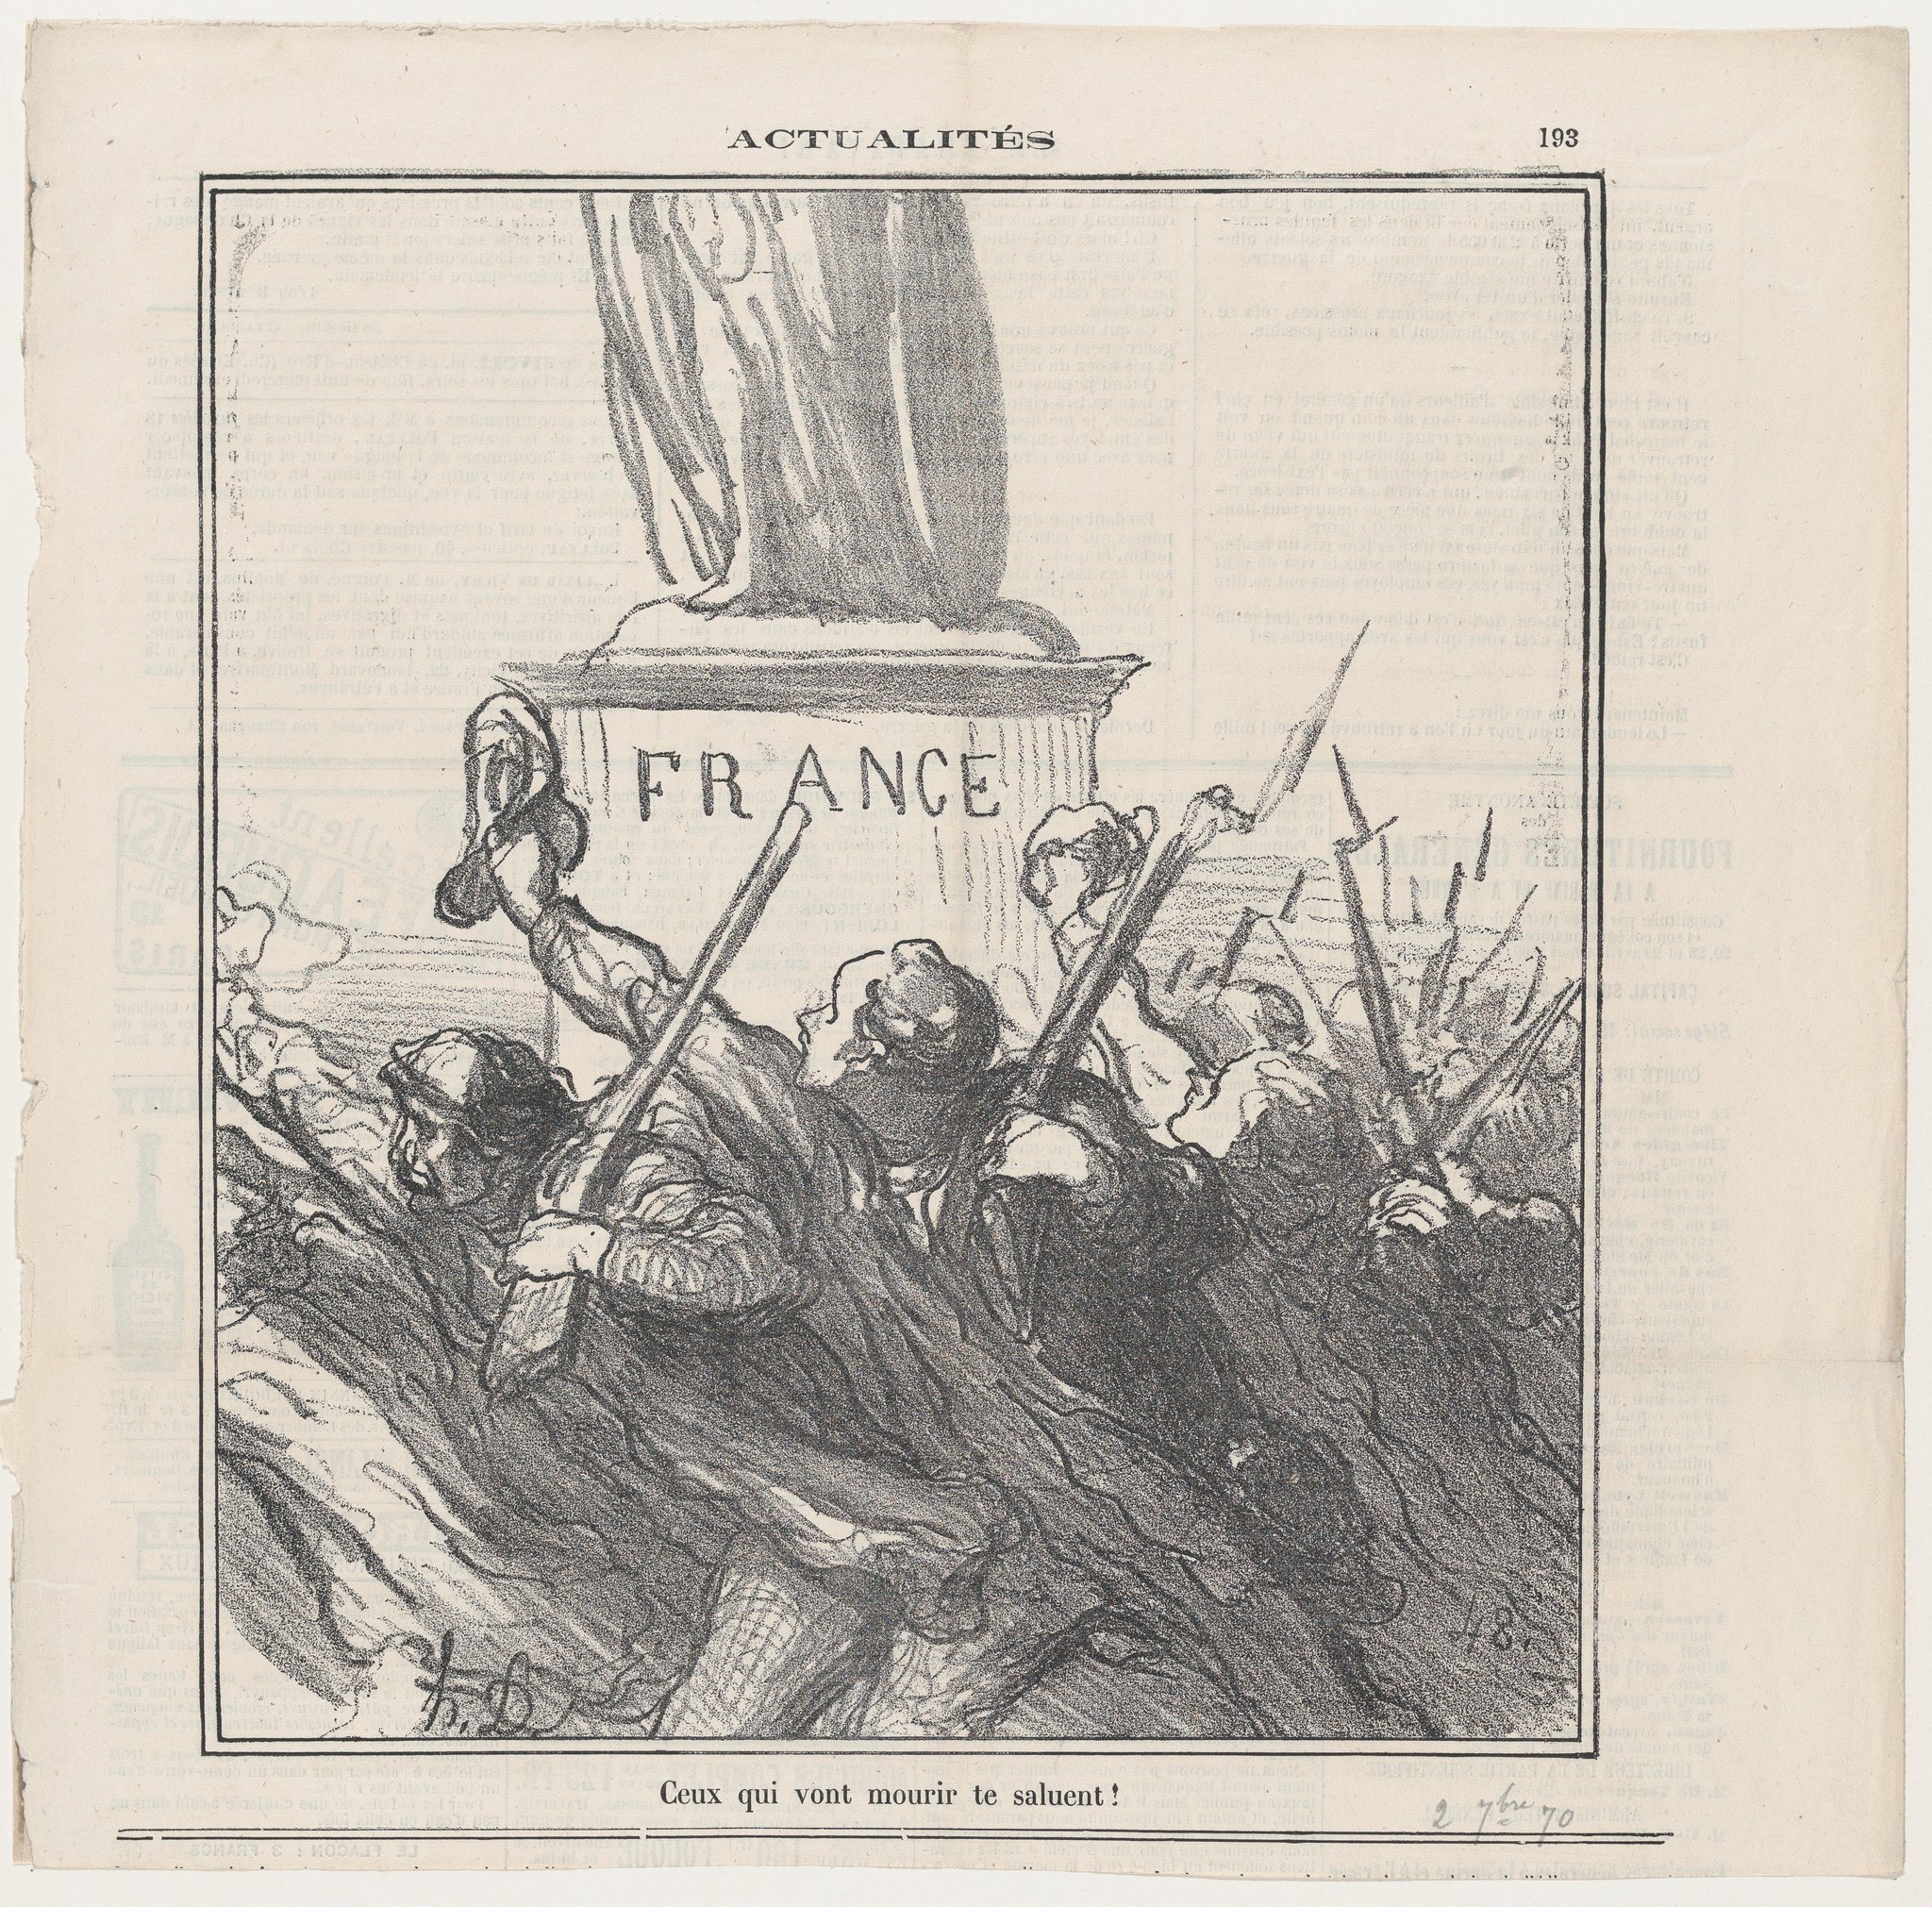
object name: print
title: Those who are about to die, salute thee, from 'News of the day,' published in Le Charivari, September 2, 1870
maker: honoré daumier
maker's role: artist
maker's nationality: french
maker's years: 1808-1879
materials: paper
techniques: lithograph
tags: weapons,men